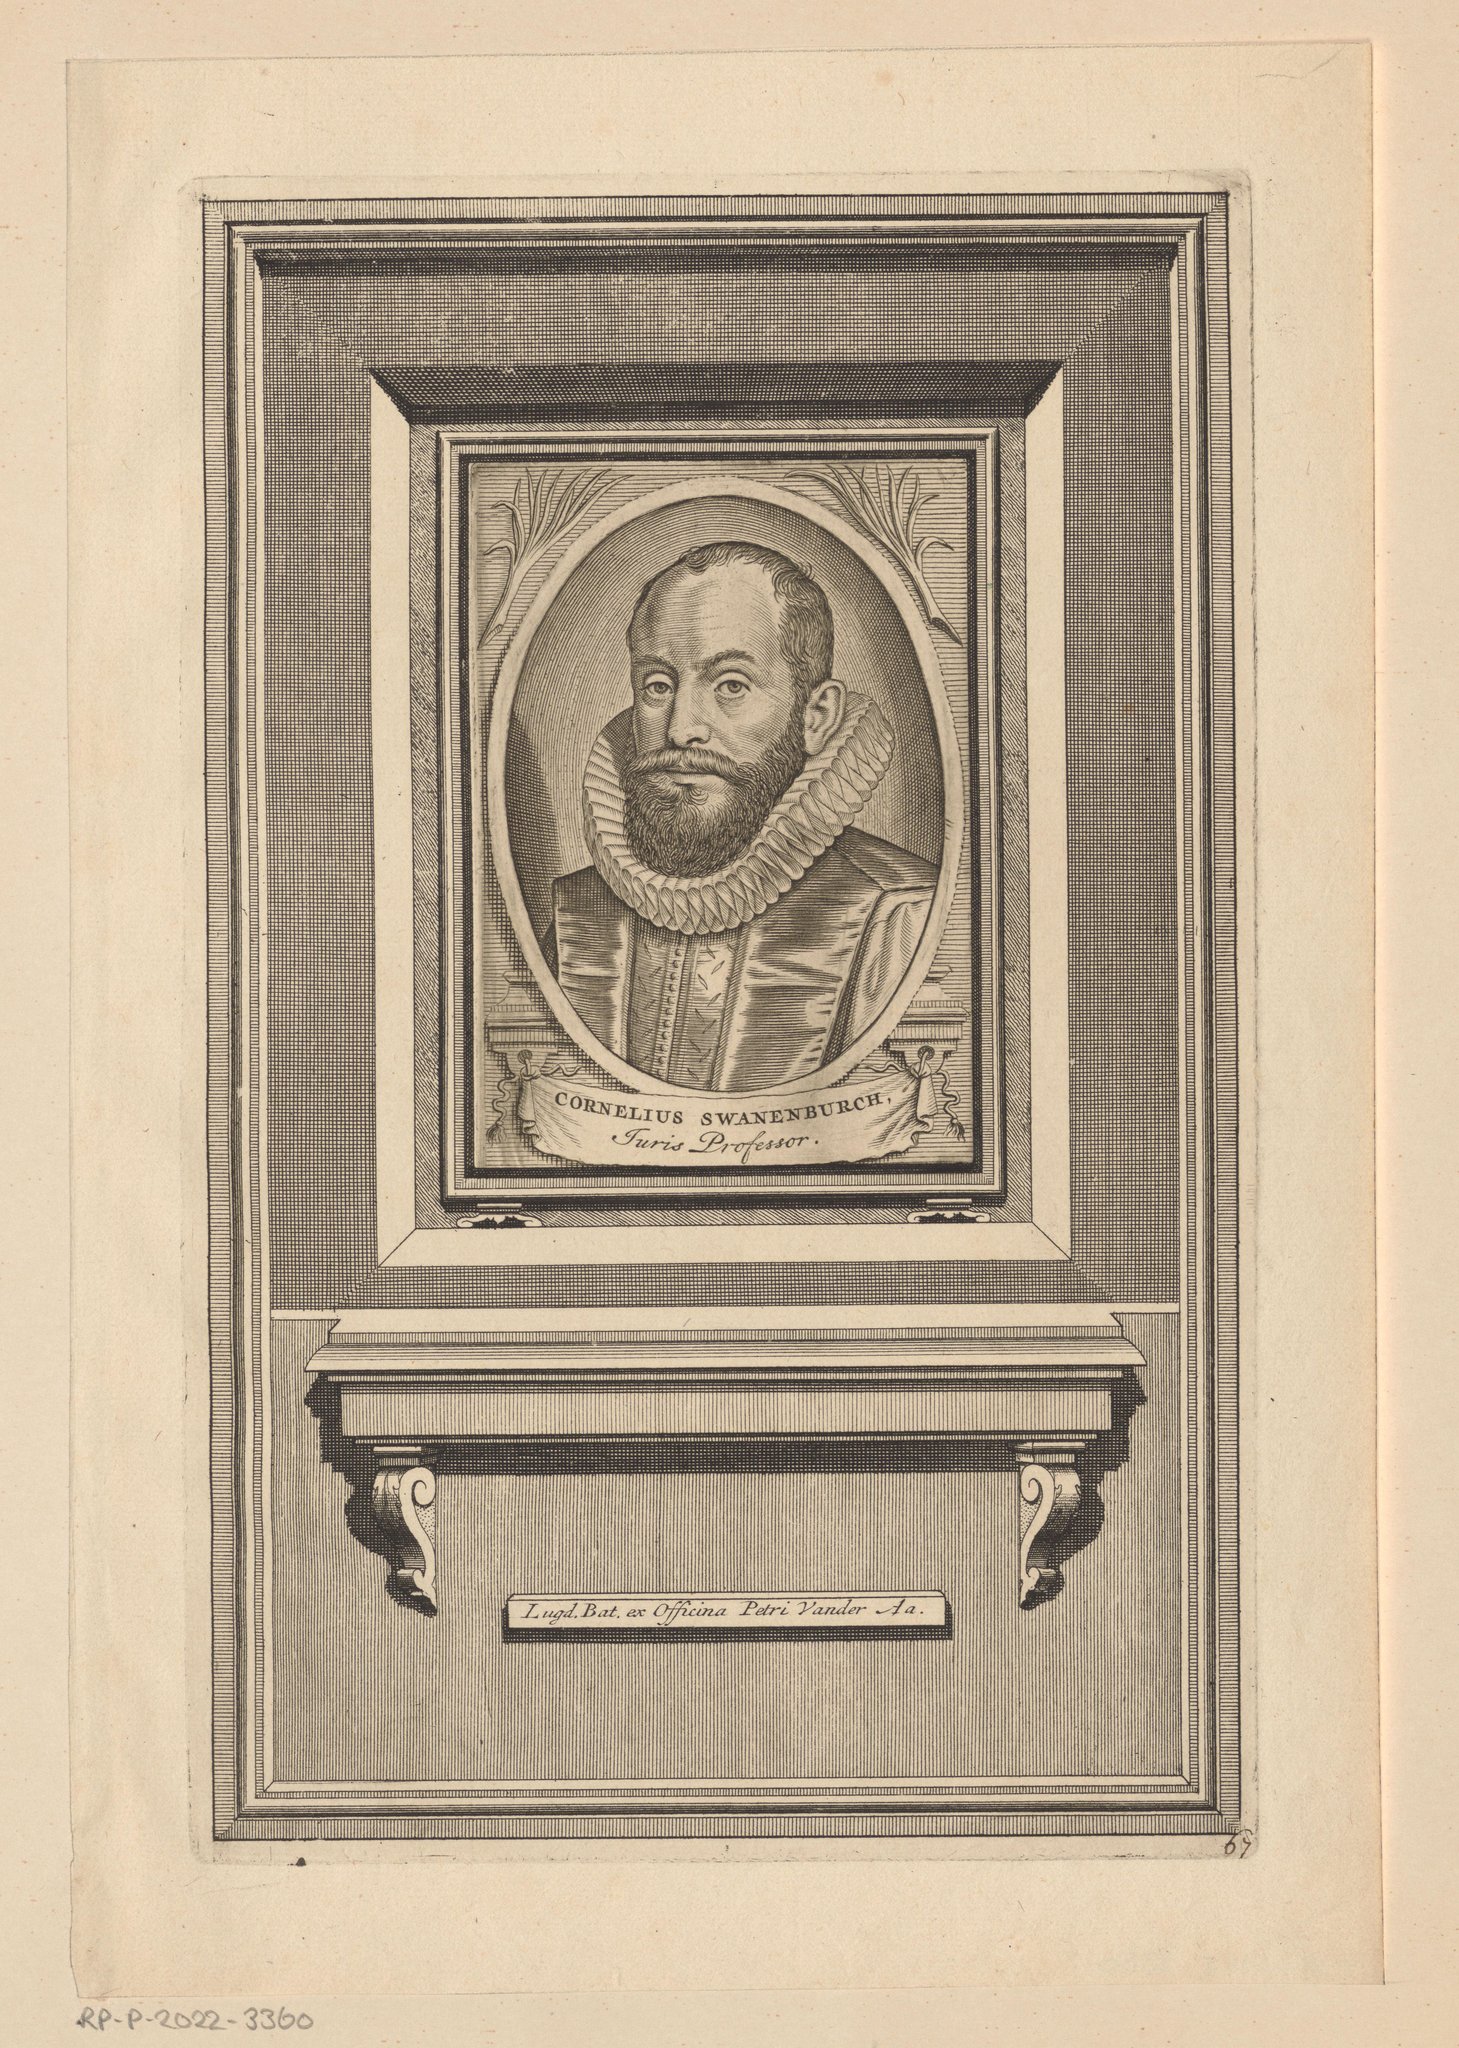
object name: print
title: Portret van Cornelius Swanenburch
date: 1716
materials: paper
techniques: engraving, etching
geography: northern netherlands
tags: historical persons, professor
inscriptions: number: ‘67’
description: Prent waarschijnlijk uit: Fundatoris, curatorum et professorum celeberrimorum, aliorumque illustrium virorum, quorum gratia, favore cura, doctrinaque adademia Lugduno-Batava (...). Leiden: Pieter van der Aa, ca. 1716.